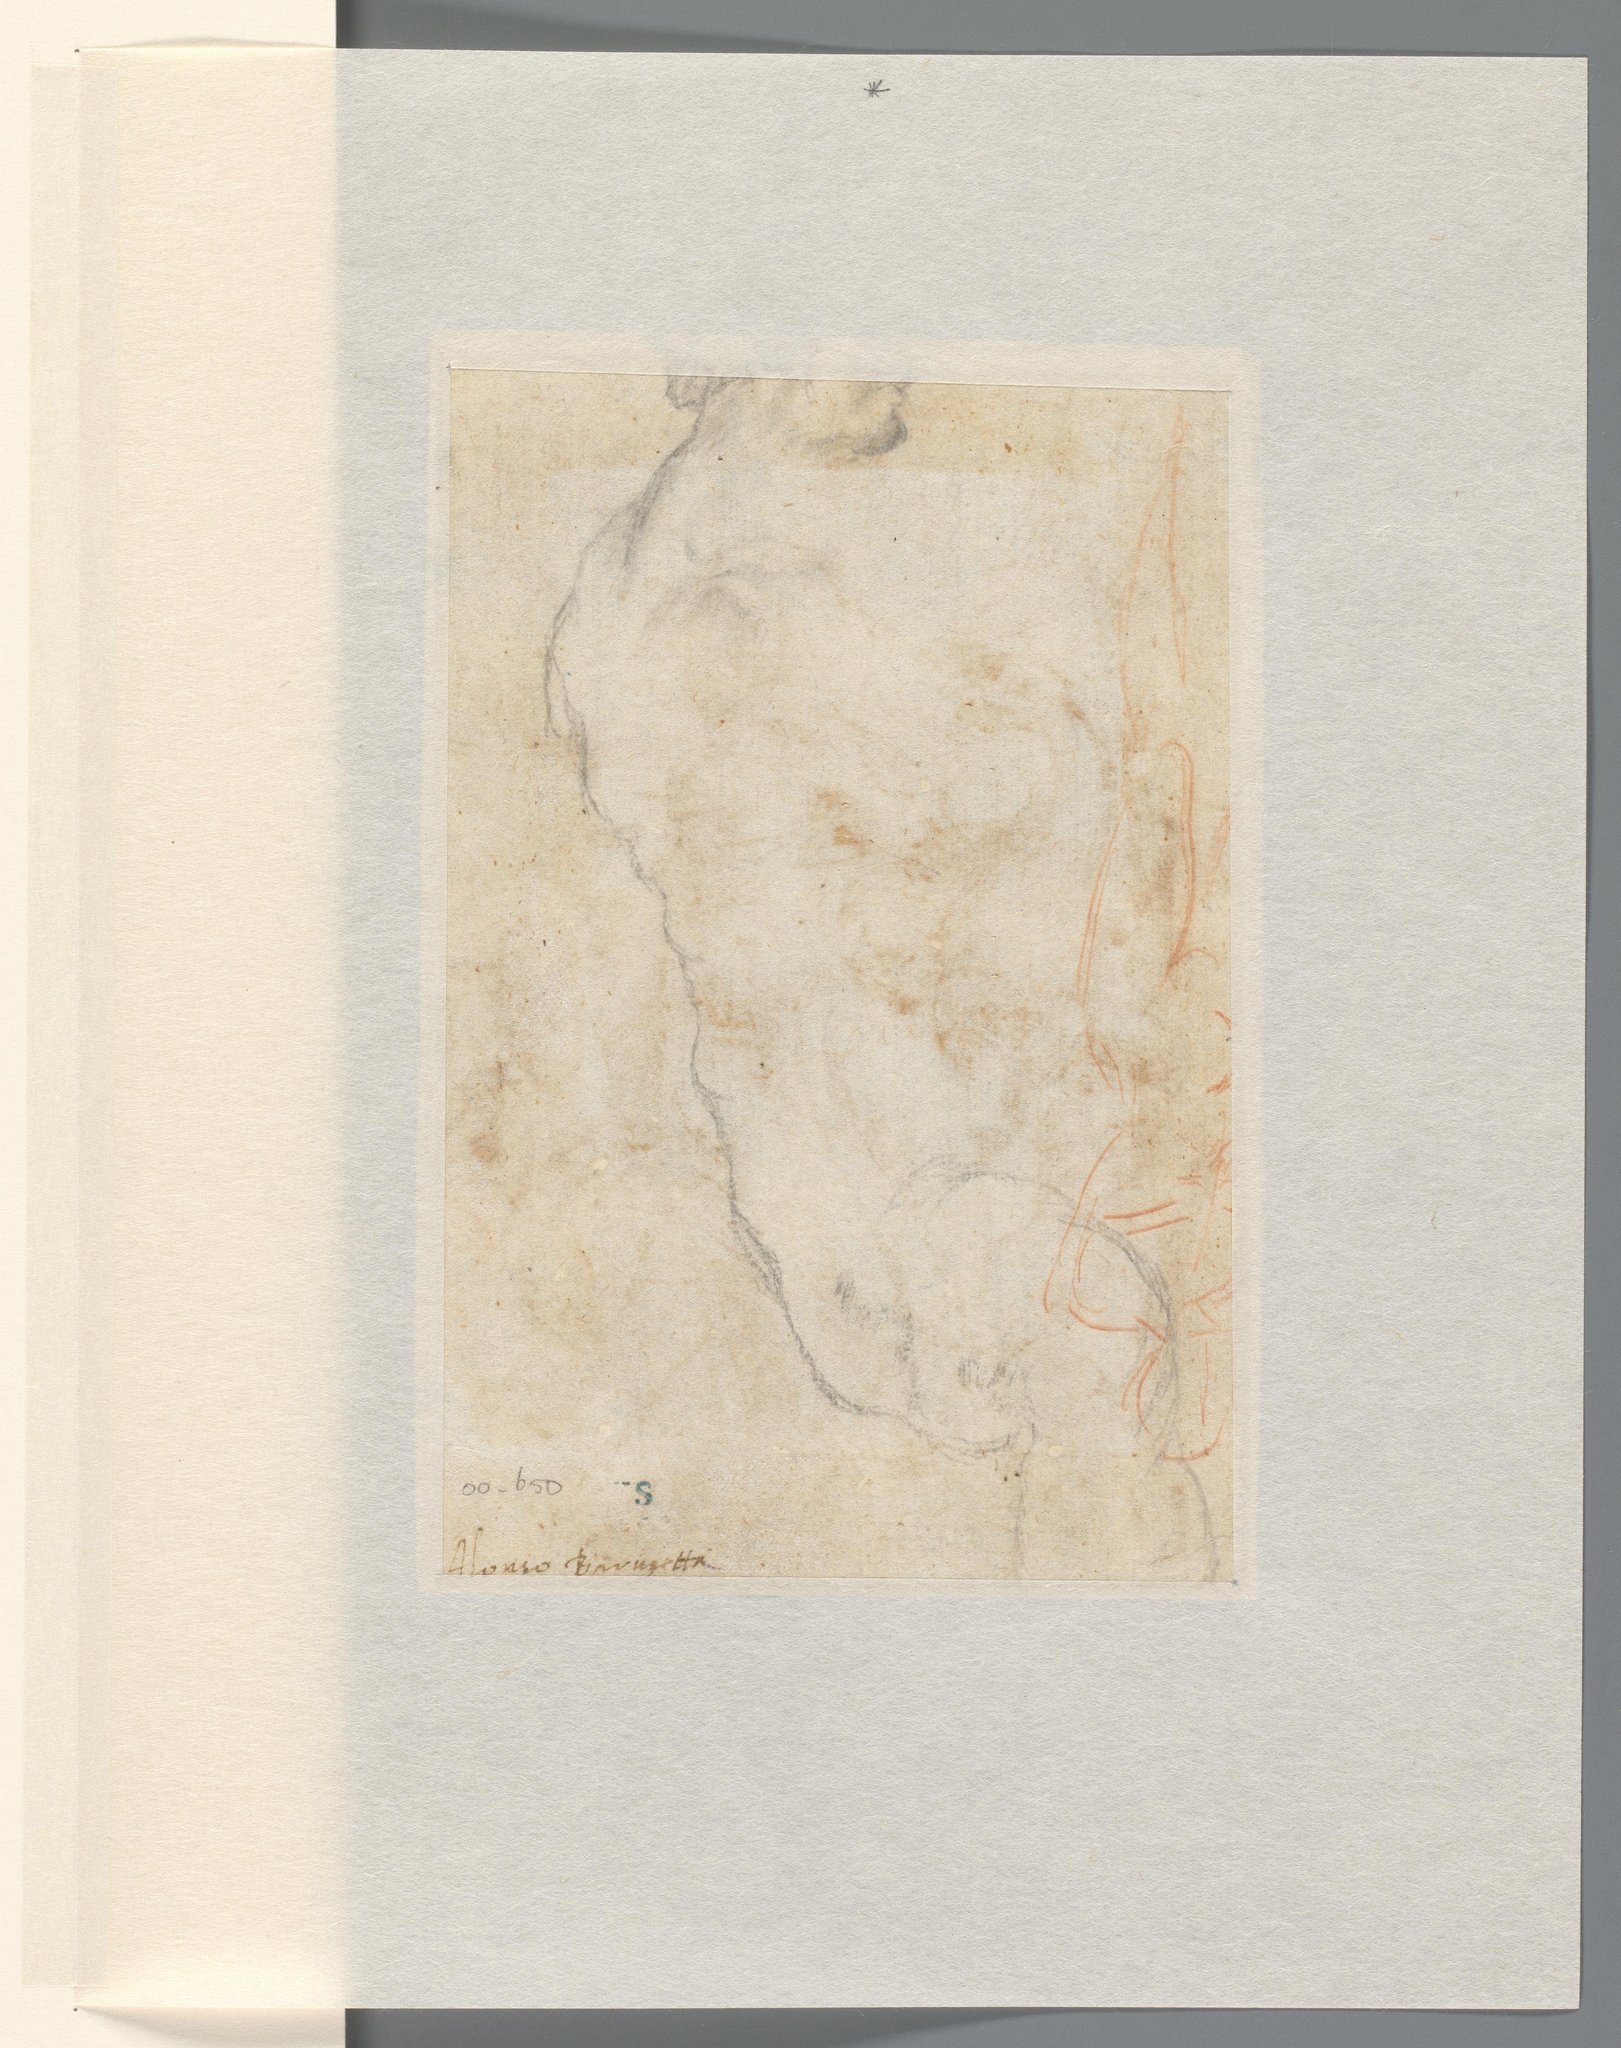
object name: drawing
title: Mannelijk rugfiguur en staande naakte man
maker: alonso berruguete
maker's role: draughtsman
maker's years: 1480-1569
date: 1500-1561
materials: chalk, paper